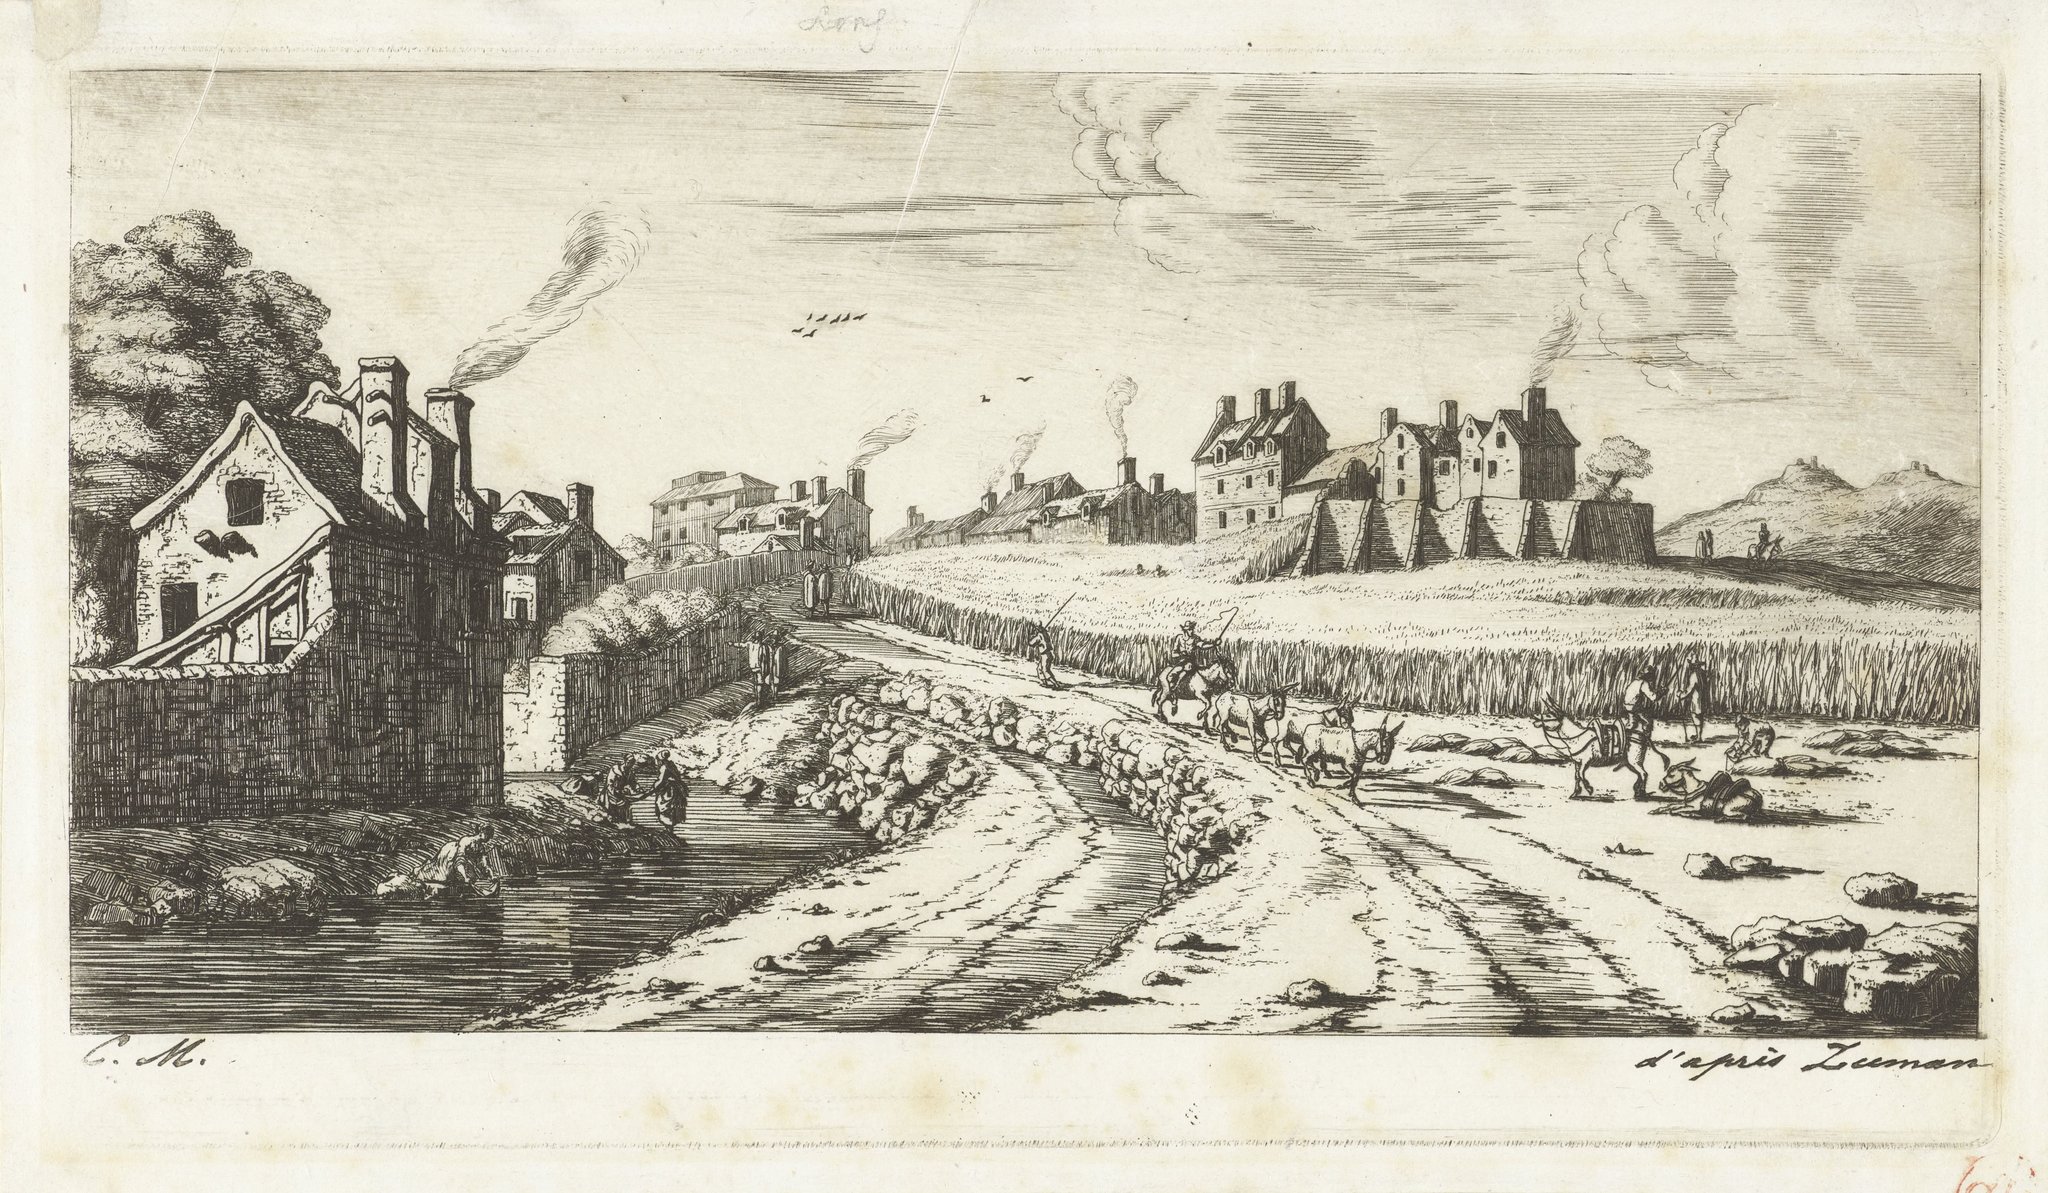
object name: print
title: Toegangsweg tot de voorstad Saint-Marceau bij Parijs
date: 1850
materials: paper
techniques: etching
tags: public road, paris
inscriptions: collector's mark: Lugt 160, collector's mark:, collector's mark: Lugt 690, collector's mark: Lugt 2228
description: Landschap aan de rand van de voorstad Saint-Marceau bij Parijs. Op de zandweg worden muildieren voortgedreven en mannen snijden korenhalmen op de akker naast de weg. Links zijn vrouwen aan het wassen bij de oever van een rivier en achter hoge muren staan huizen.